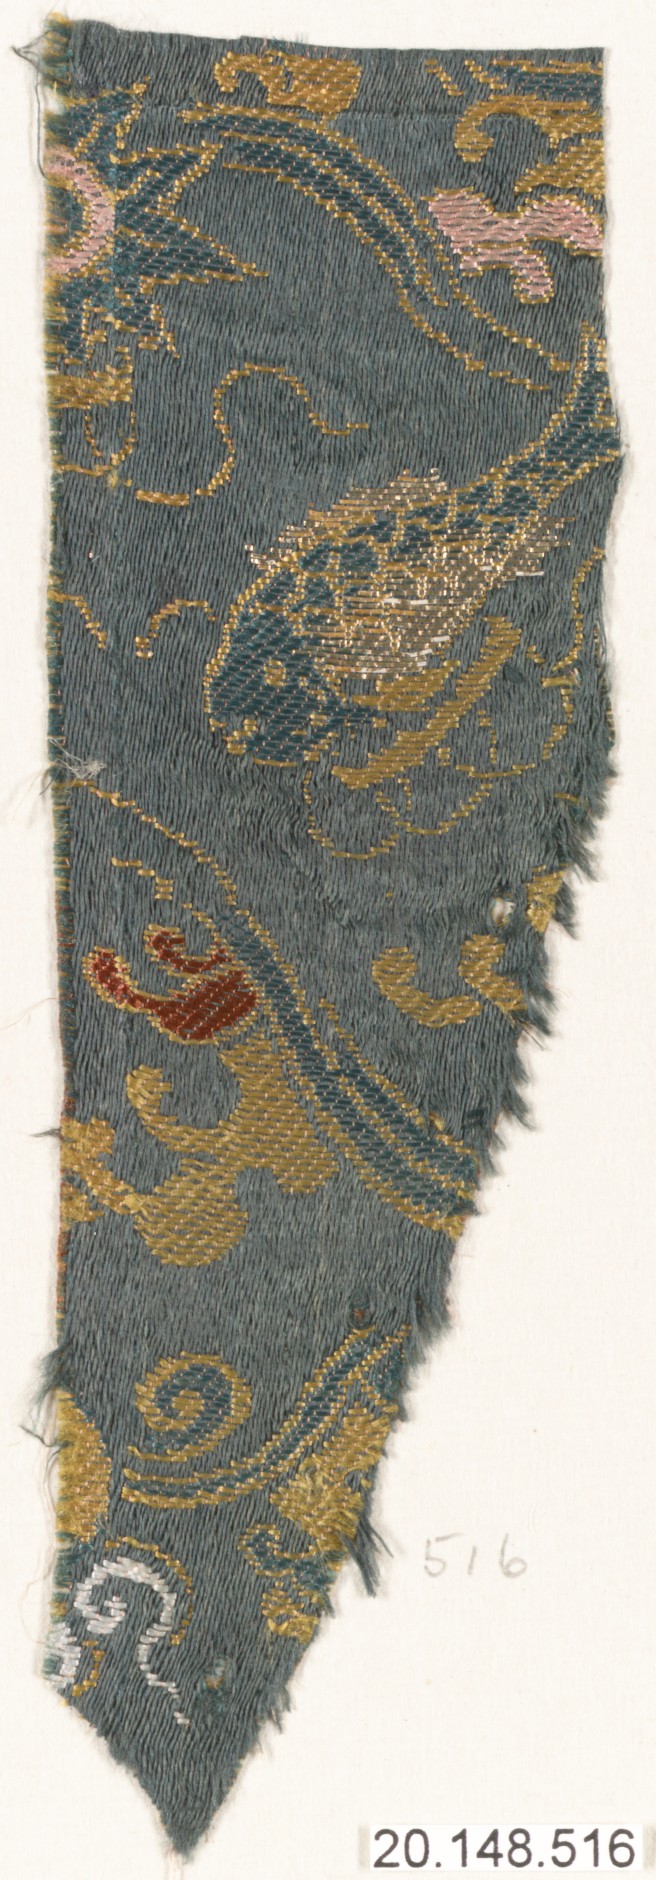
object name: piece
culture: japanese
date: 1701-1800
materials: silk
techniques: compound weave